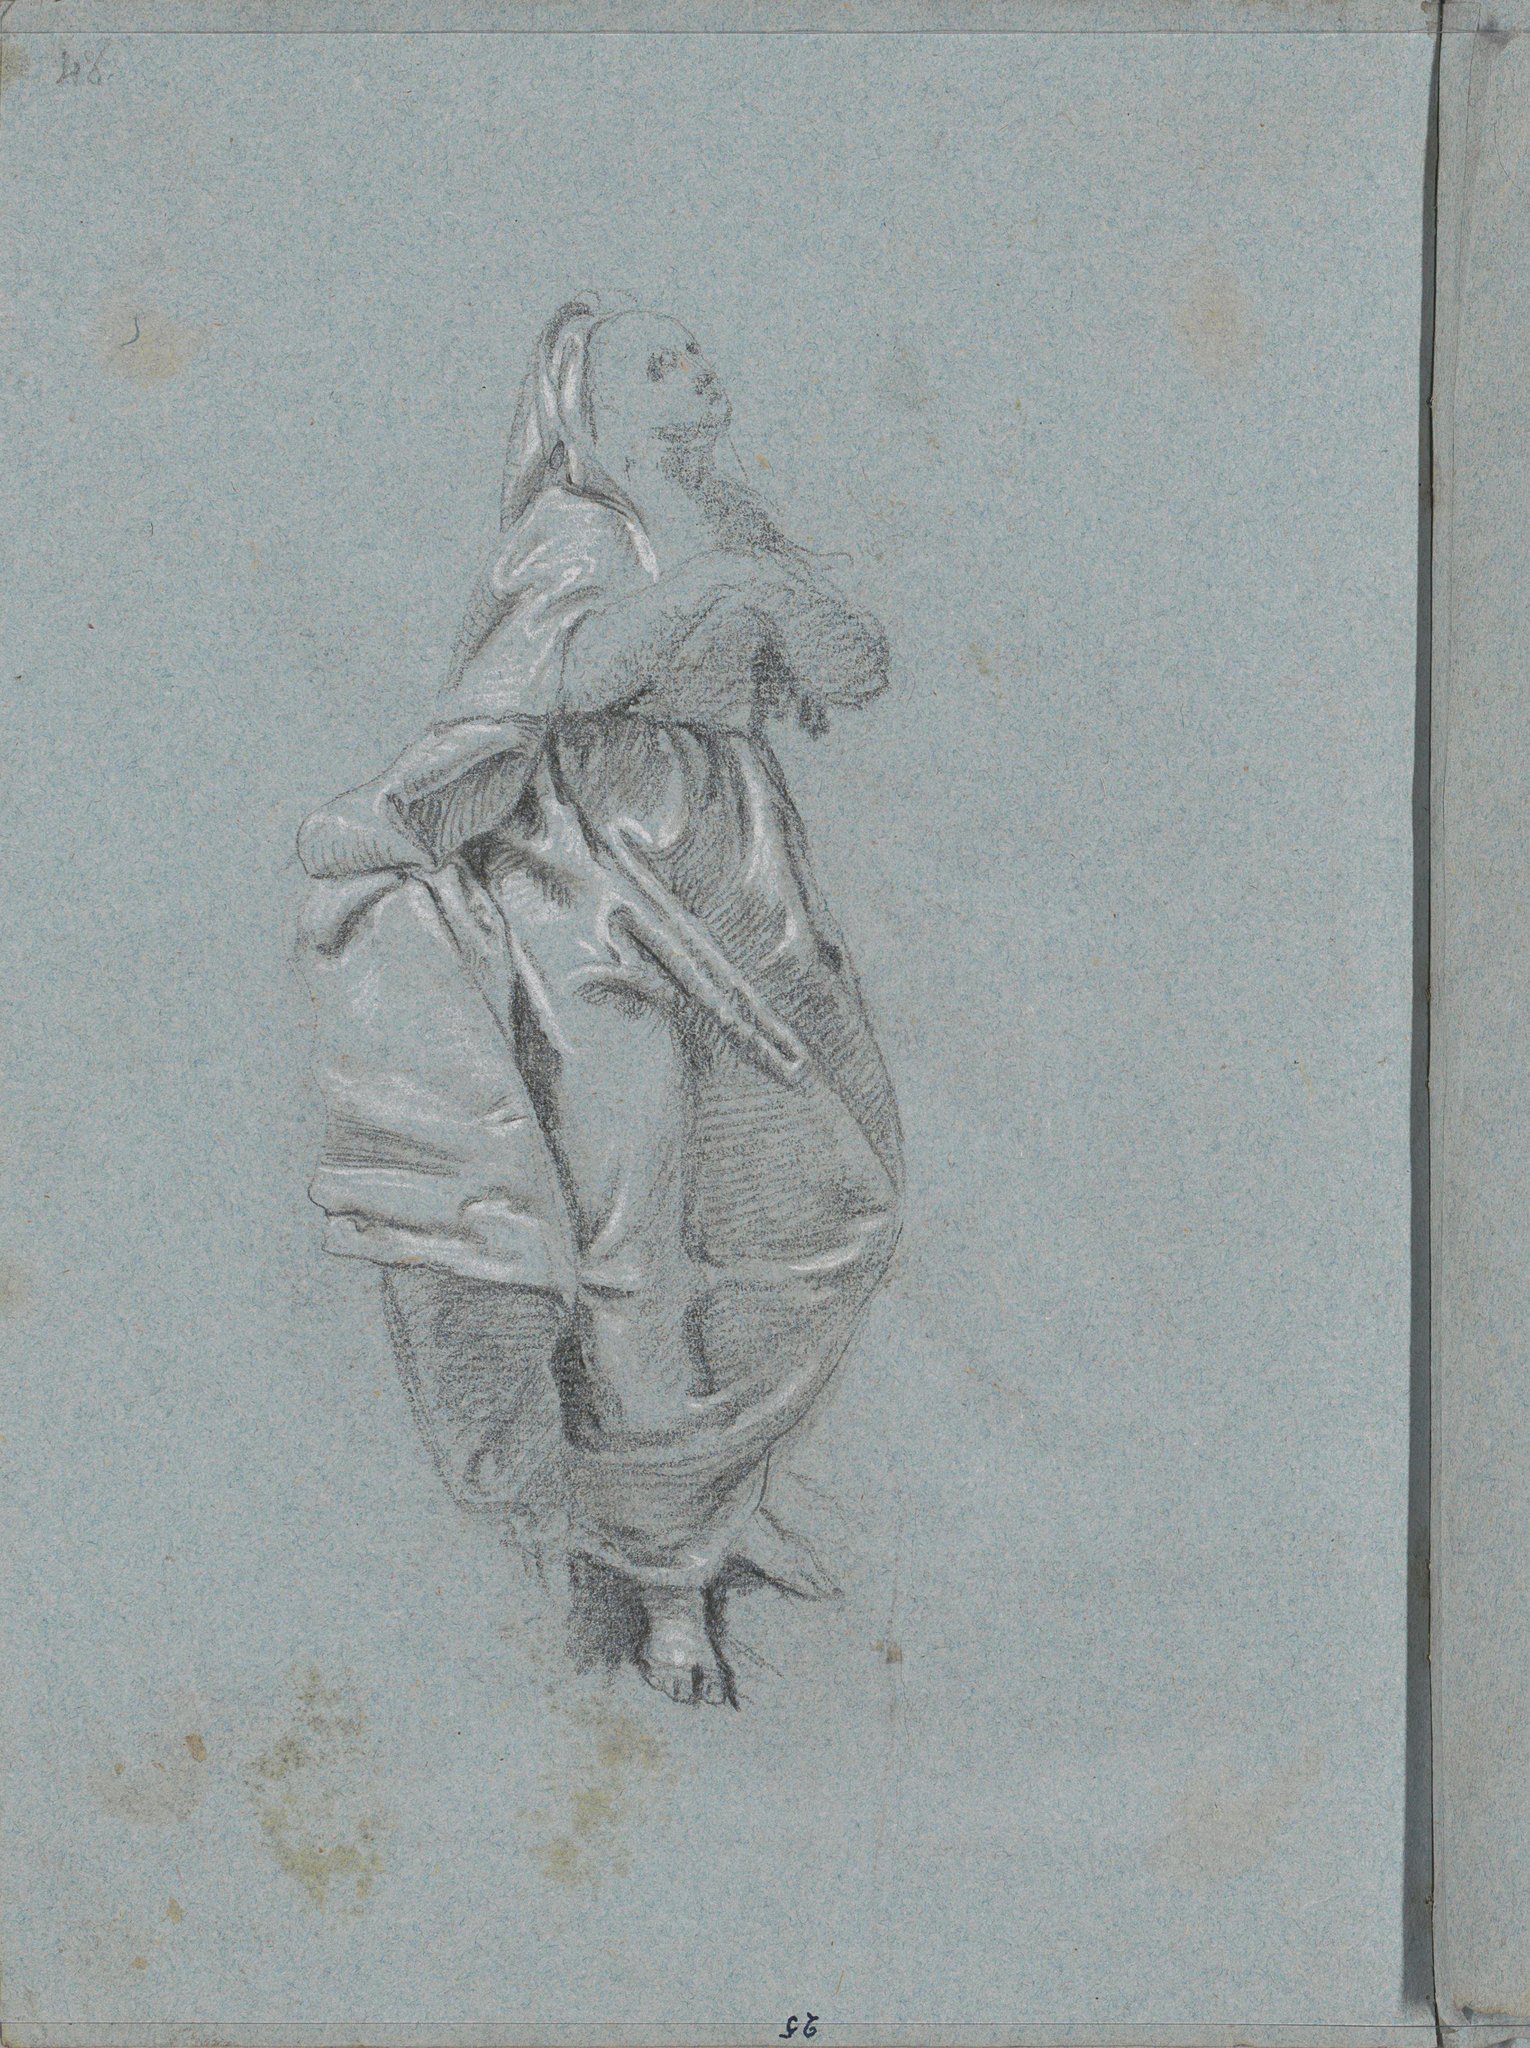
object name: sketchbook leaf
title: Staande vrouw in lange mantel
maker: lorenzo baldissera tiepolo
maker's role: draughtsman, print maker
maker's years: 1736-1776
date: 1751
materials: chalk, paper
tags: standing figure - aa - female human figure, drapery, draped garment, 'gewandgebung', one person praying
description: De vrouw houdt de handen voor de borst en het hoofd omhoog, vermoedelijk in een bidhouding. Bladzijde 48 uit een schetsboek met 158 bladzijden.